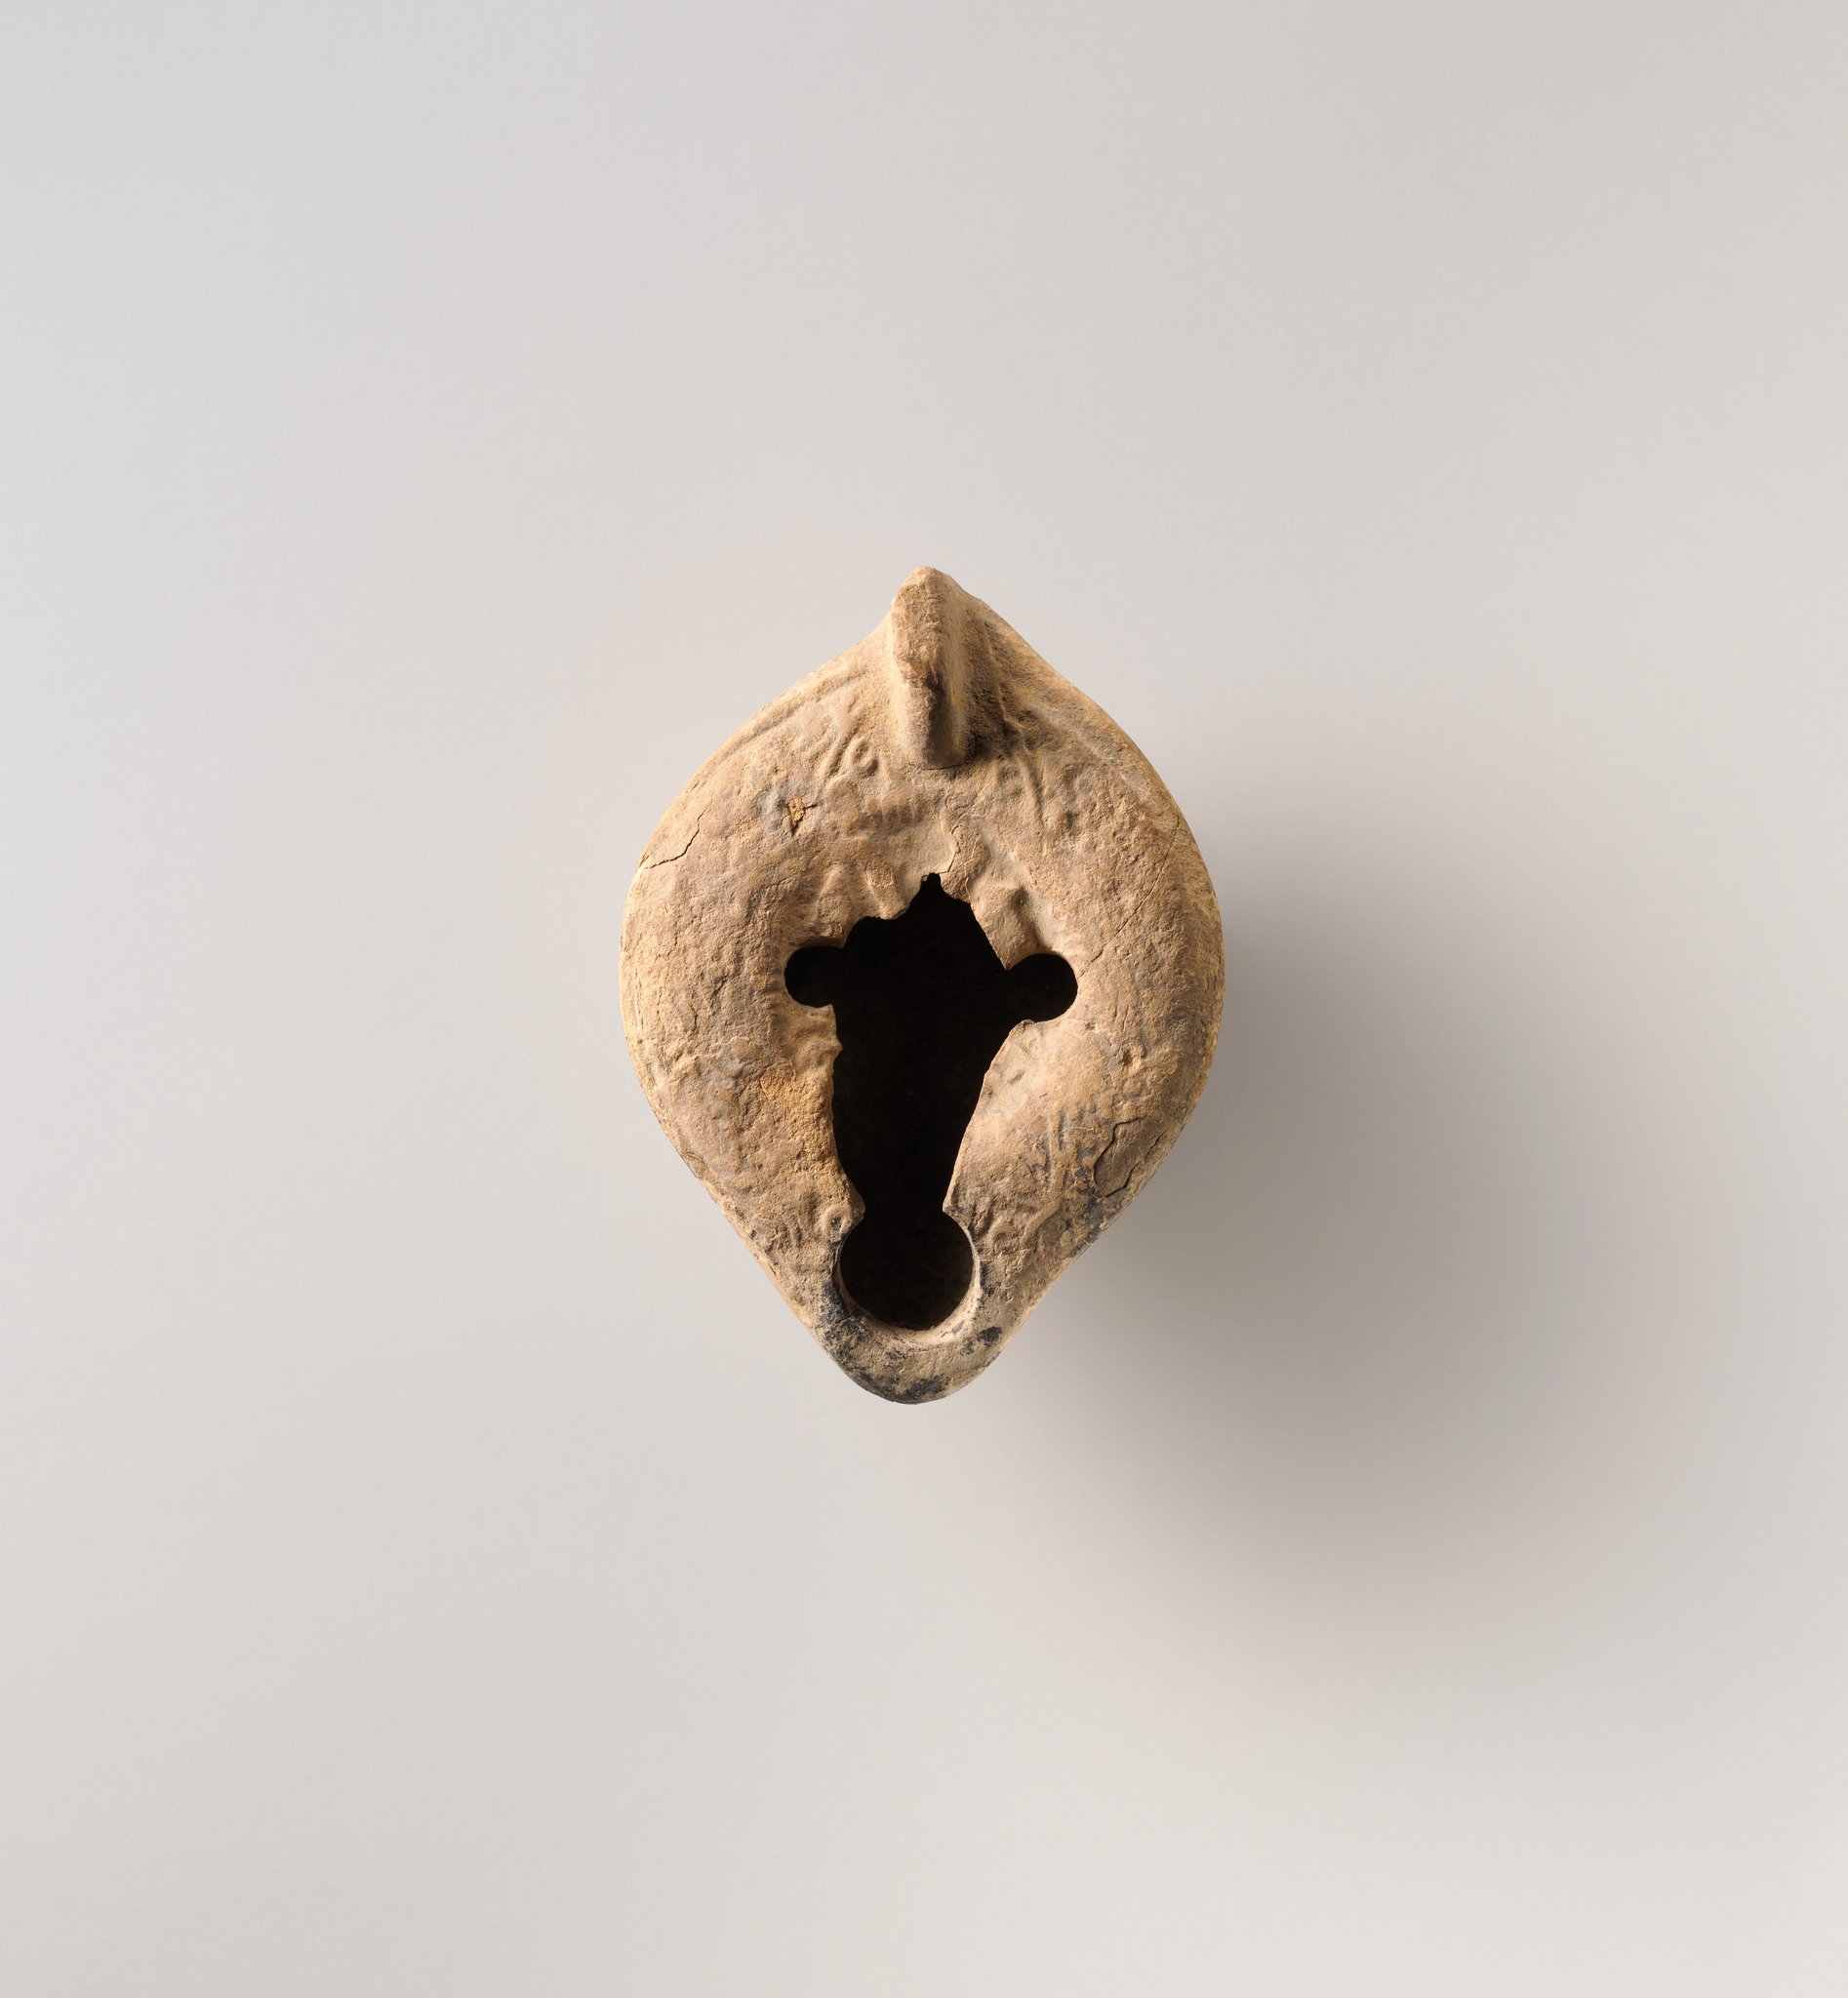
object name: lamp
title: Terracotta oil lamp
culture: roman, cypriot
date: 301-500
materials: terracotta